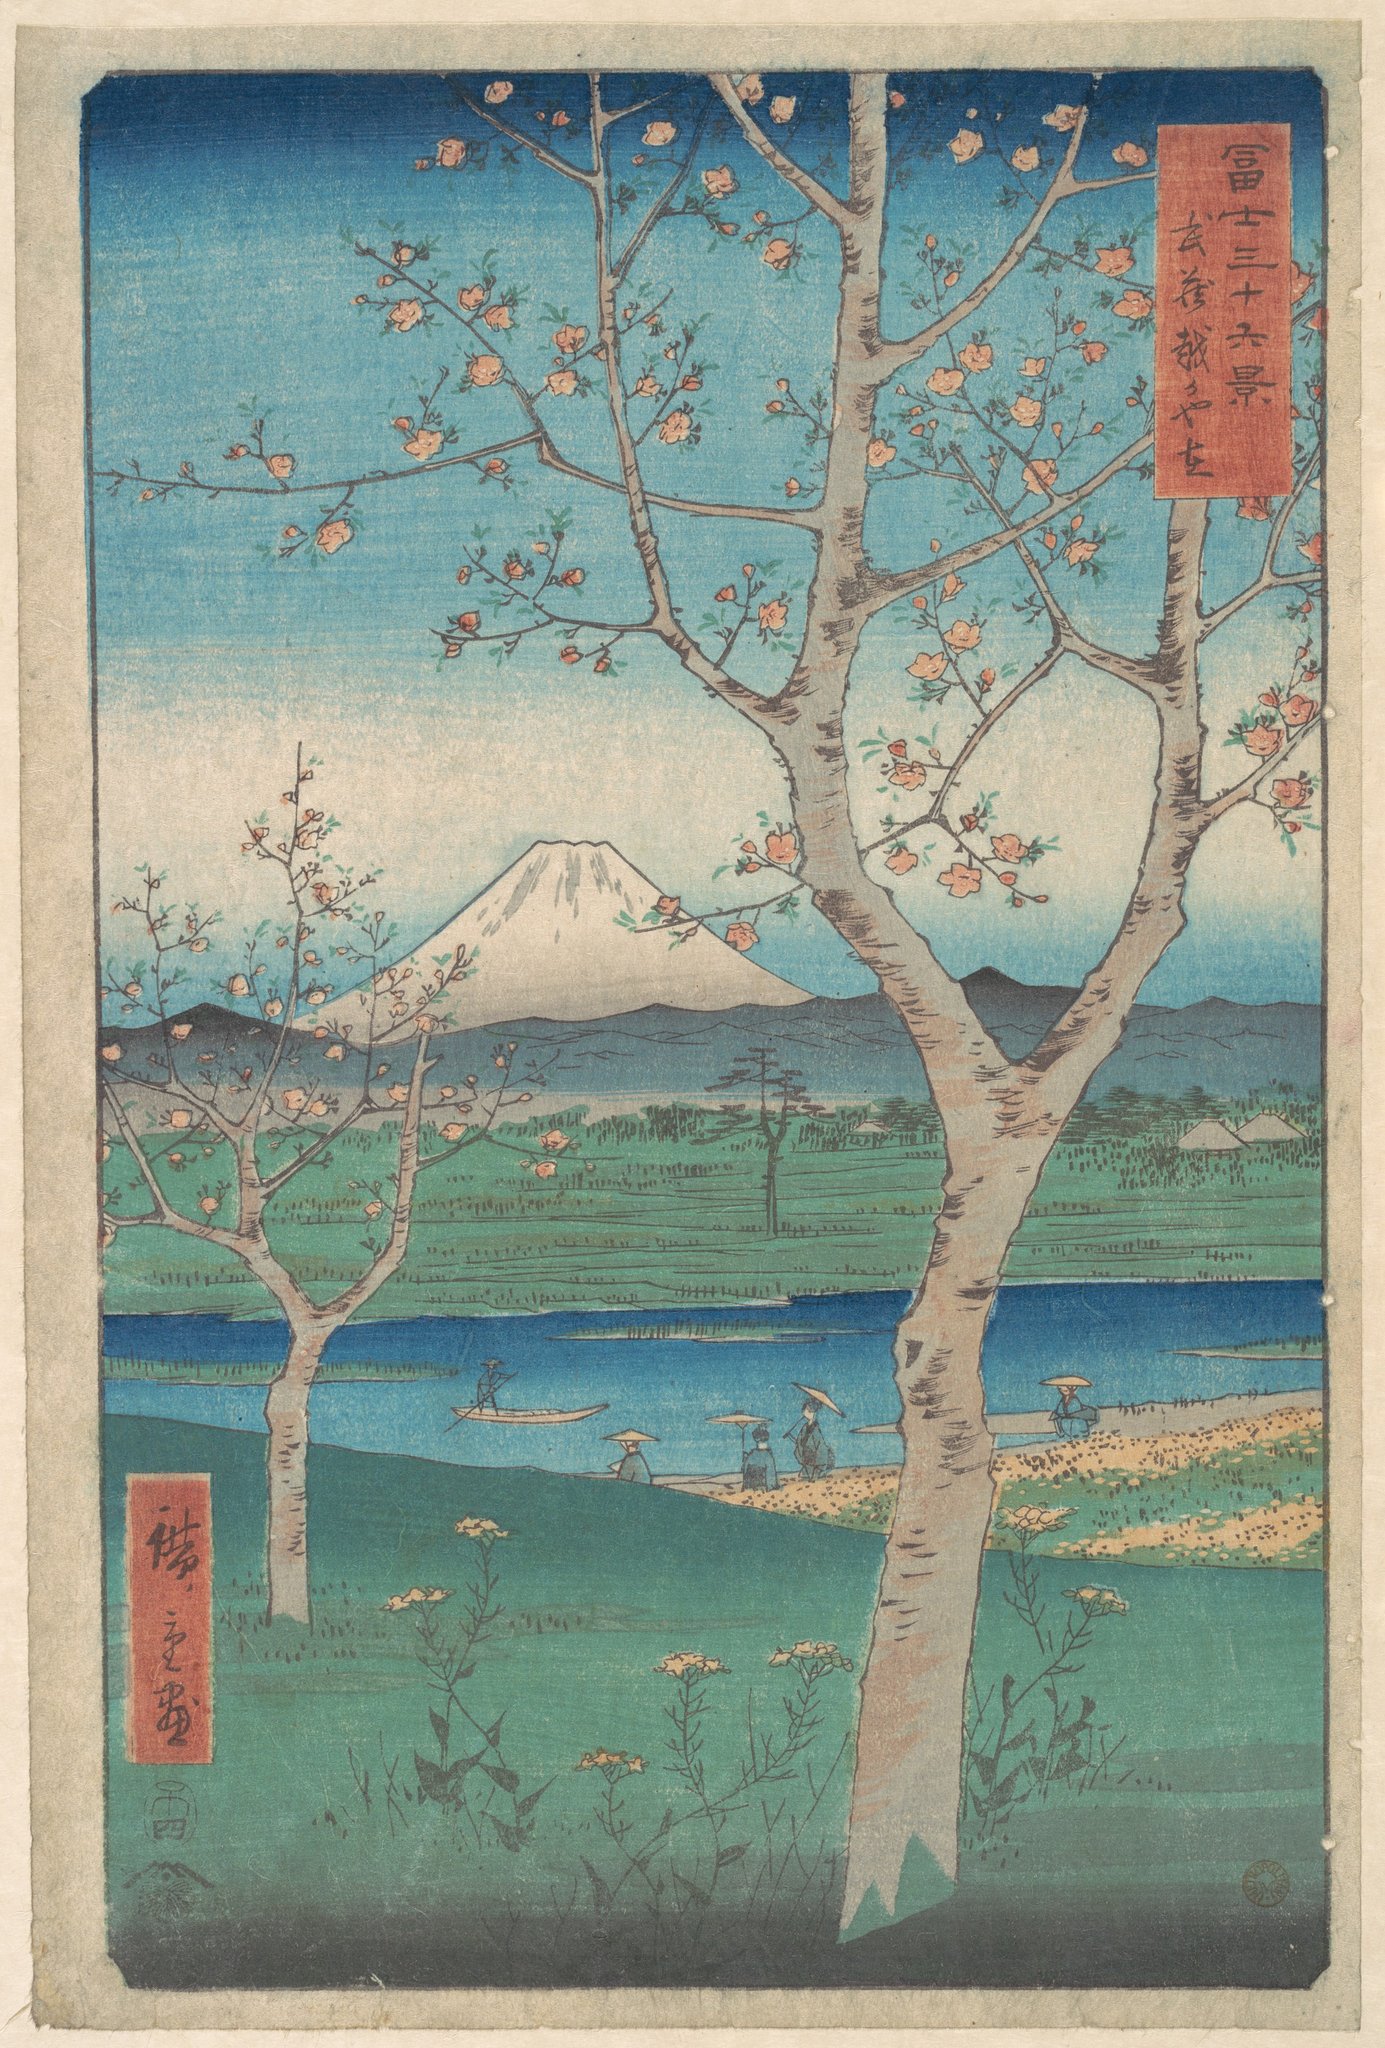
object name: print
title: View of Mount Fuji from Koshigaya, Province of Musashi (Musashi, Koshigaya Zai), from the series Thirty-six Views of Mount Fuji (Fugaku sanjūrokkei)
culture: japanese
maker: utagawa hiroshige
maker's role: artist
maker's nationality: japanese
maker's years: 1797-1858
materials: ink, paper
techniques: woodblock print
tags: mountains,landscapes